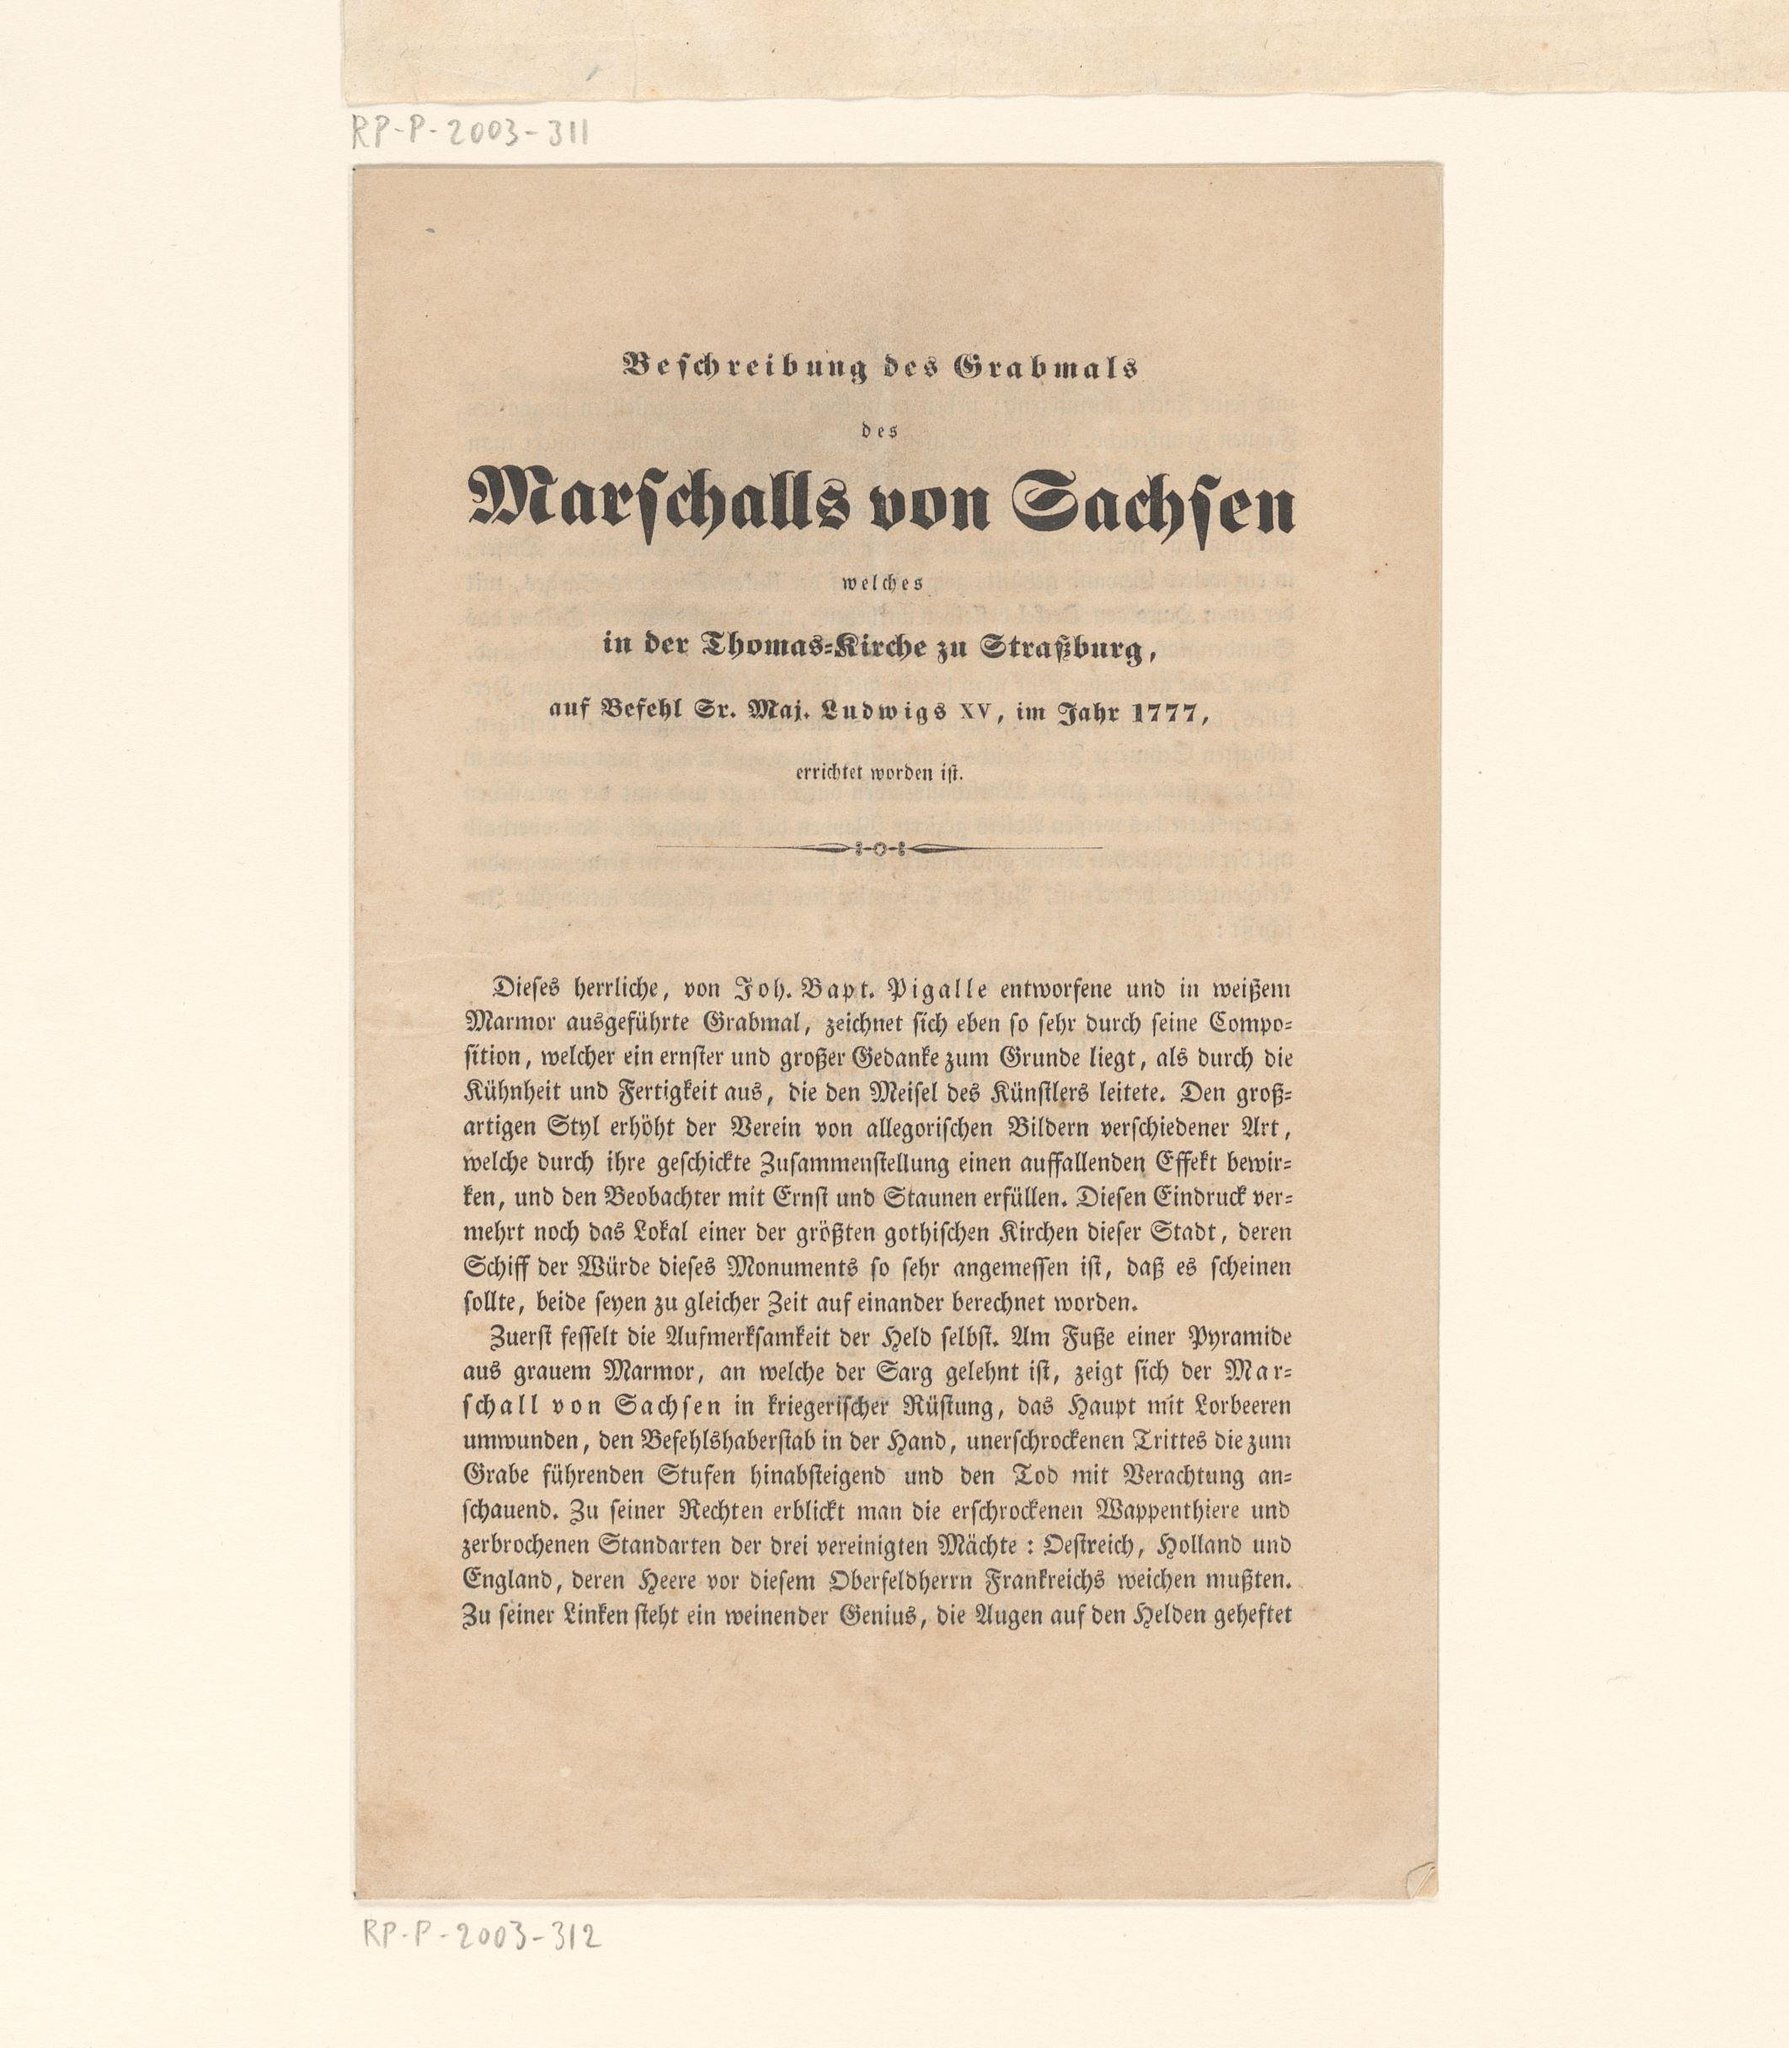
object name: text sheet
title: Beschrijving van grafmonumenten in de Sint Thomaskerk te Straatsburg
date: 1843-1876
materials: paper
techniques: letterpress printing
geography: straatsburg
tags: politician, publisher, physicist, grave, tomb, monument, statue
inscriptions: collector's mark: Lugt 2228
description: Het boek vermeld in ieder geval de gedenkmonumenten van Maurits van Saksen, Johann Daniel Schöpflin, Christoph Wilhelm Koch, Friedrich Carl Timotheus Emmerich, Johann Schweighäuser, Johann Ludwig Alexander Herrenschneider, Jeremias Jacob Oberlin en Franz Daniel Reisseissen.